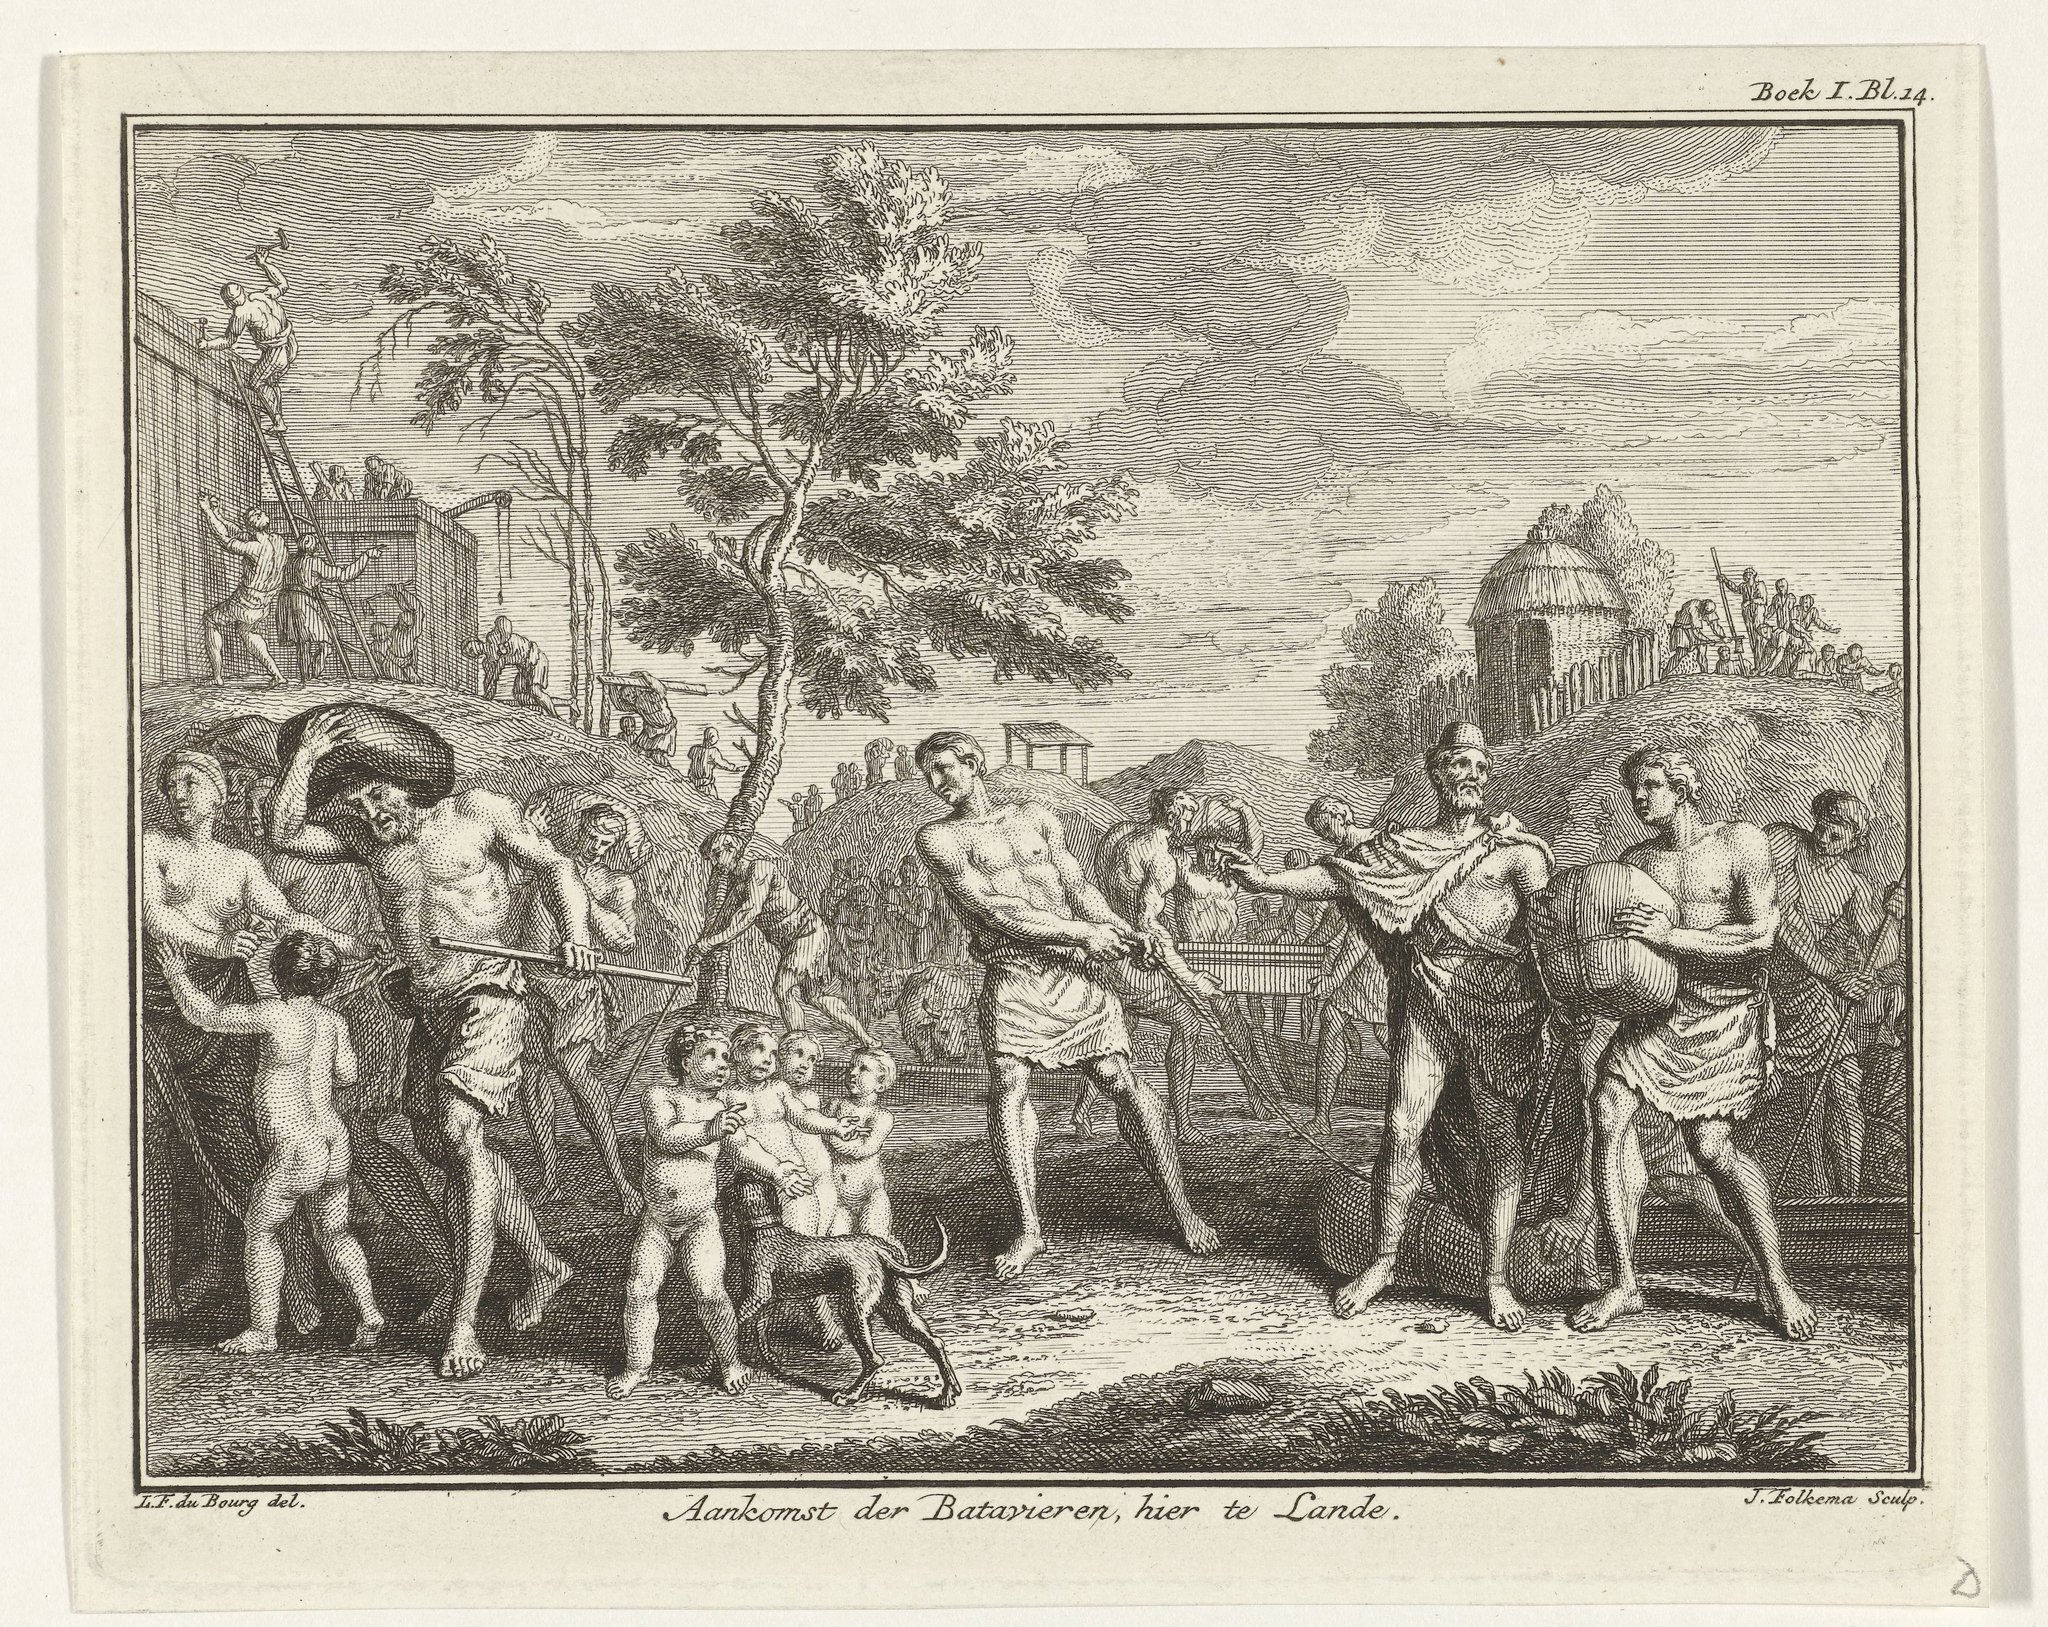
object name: print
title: Aankomst der Batavieren, hier te Lande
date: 1749-1759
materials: paper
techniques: etching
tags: extinct, 'historical' peoples (with name), netherlands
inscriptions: collector's mark: Lugt 2228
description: Illustratie voor: Jan Wagenaar, Vaderlandsche historie, Amsterdam 1749-1759, boek I, p. 14.